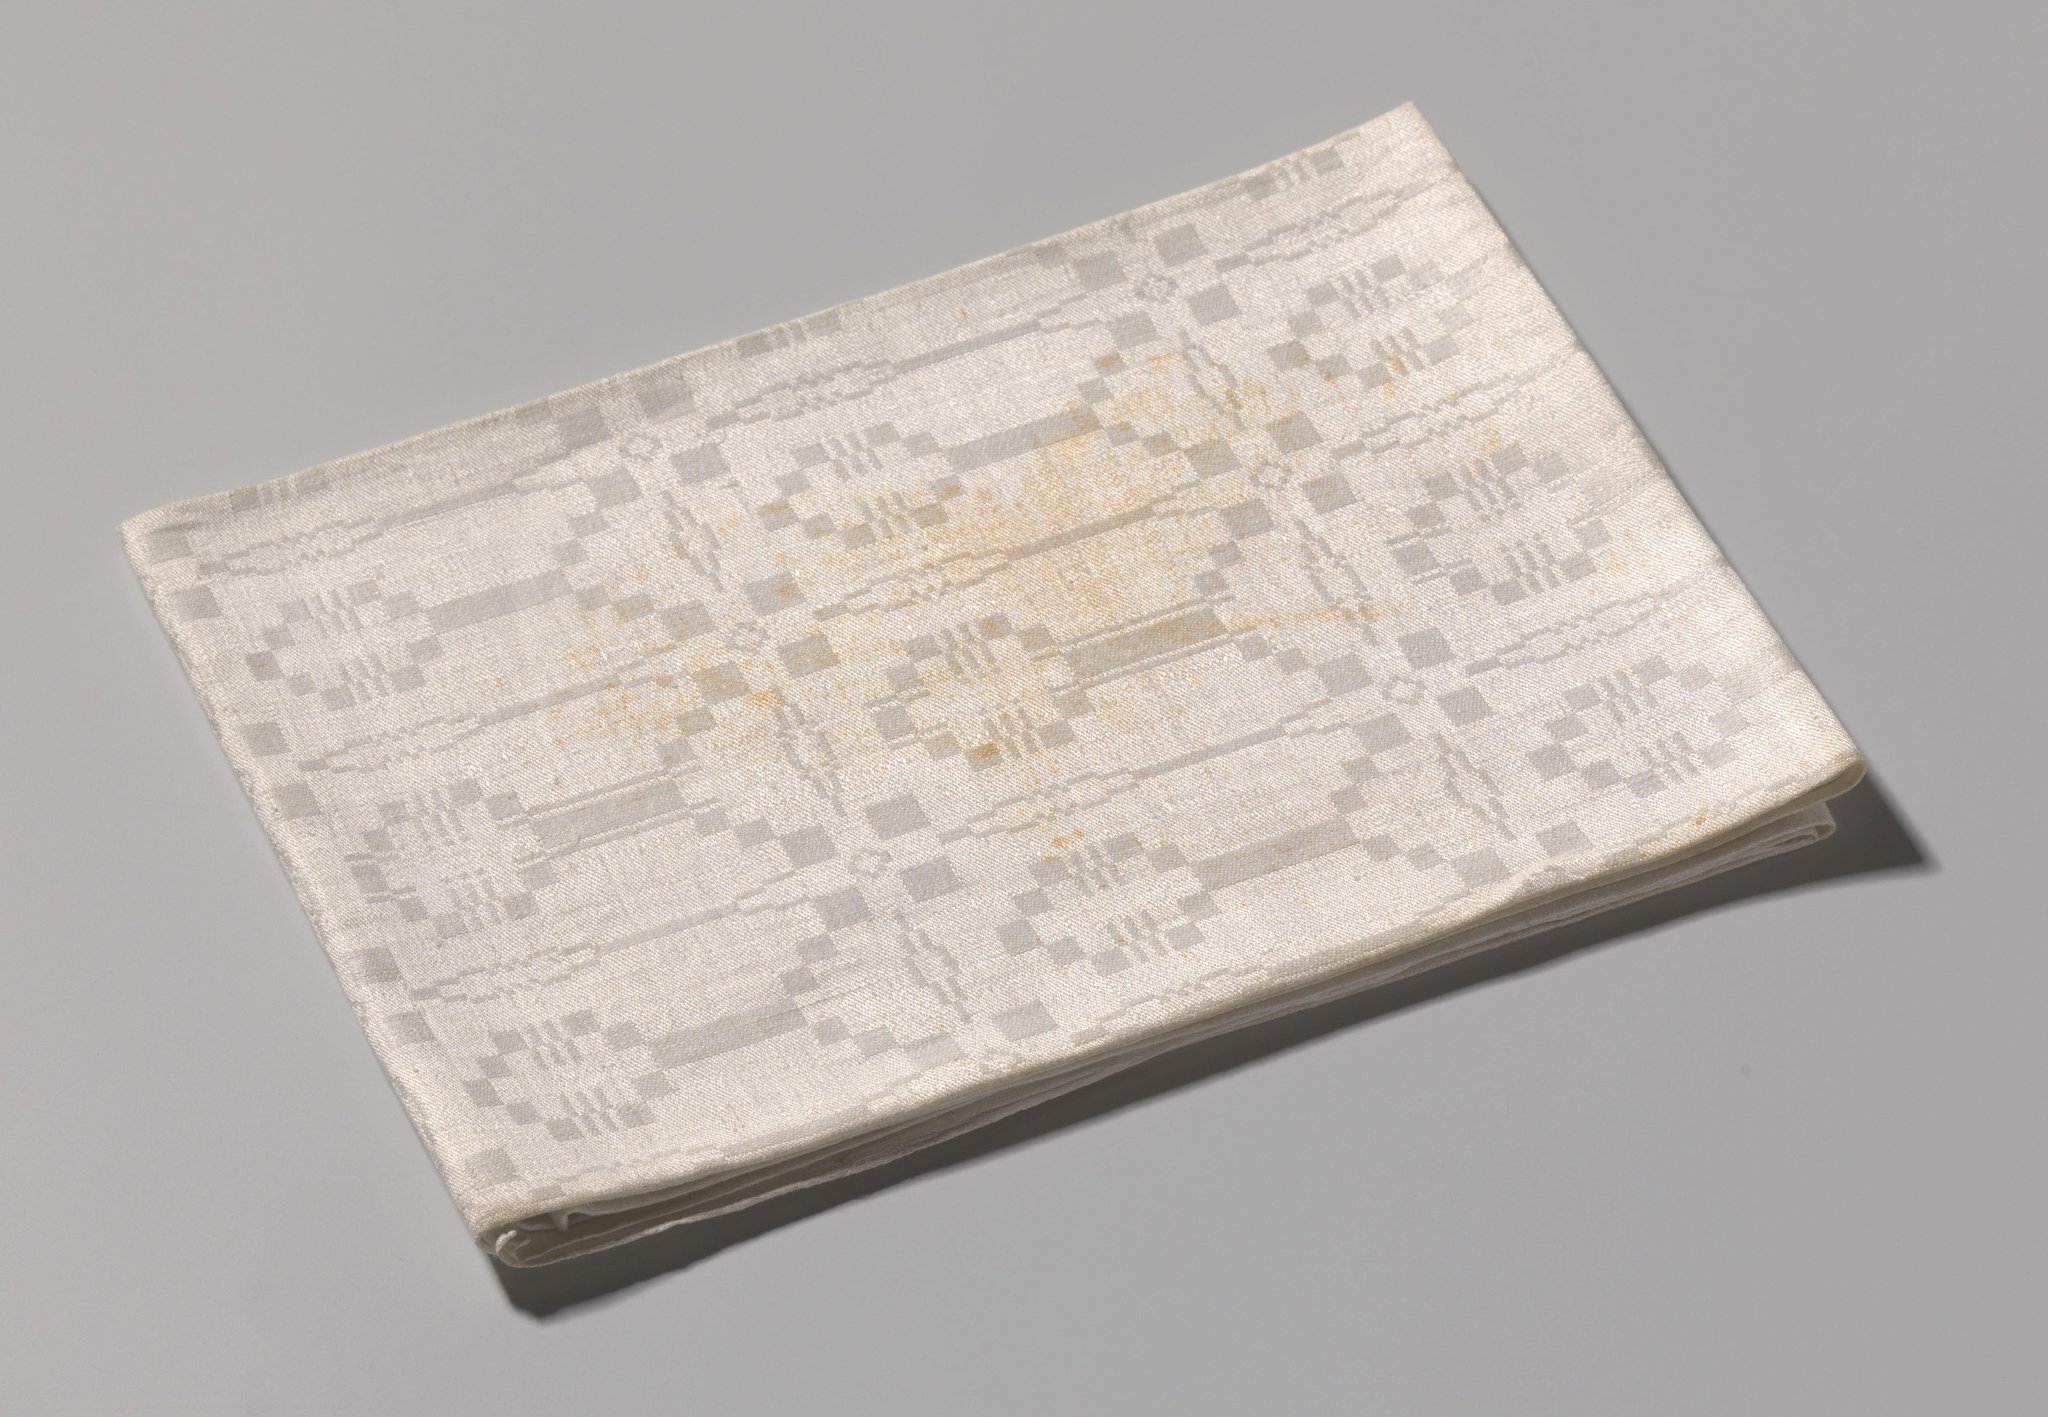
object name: napkin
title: Servet van linnen met pellenpatroon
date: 1726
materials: linen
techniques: peeled fabric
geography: northern netherlands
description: wit linnen servet met pellen patroon, merk GS 60 en 1726